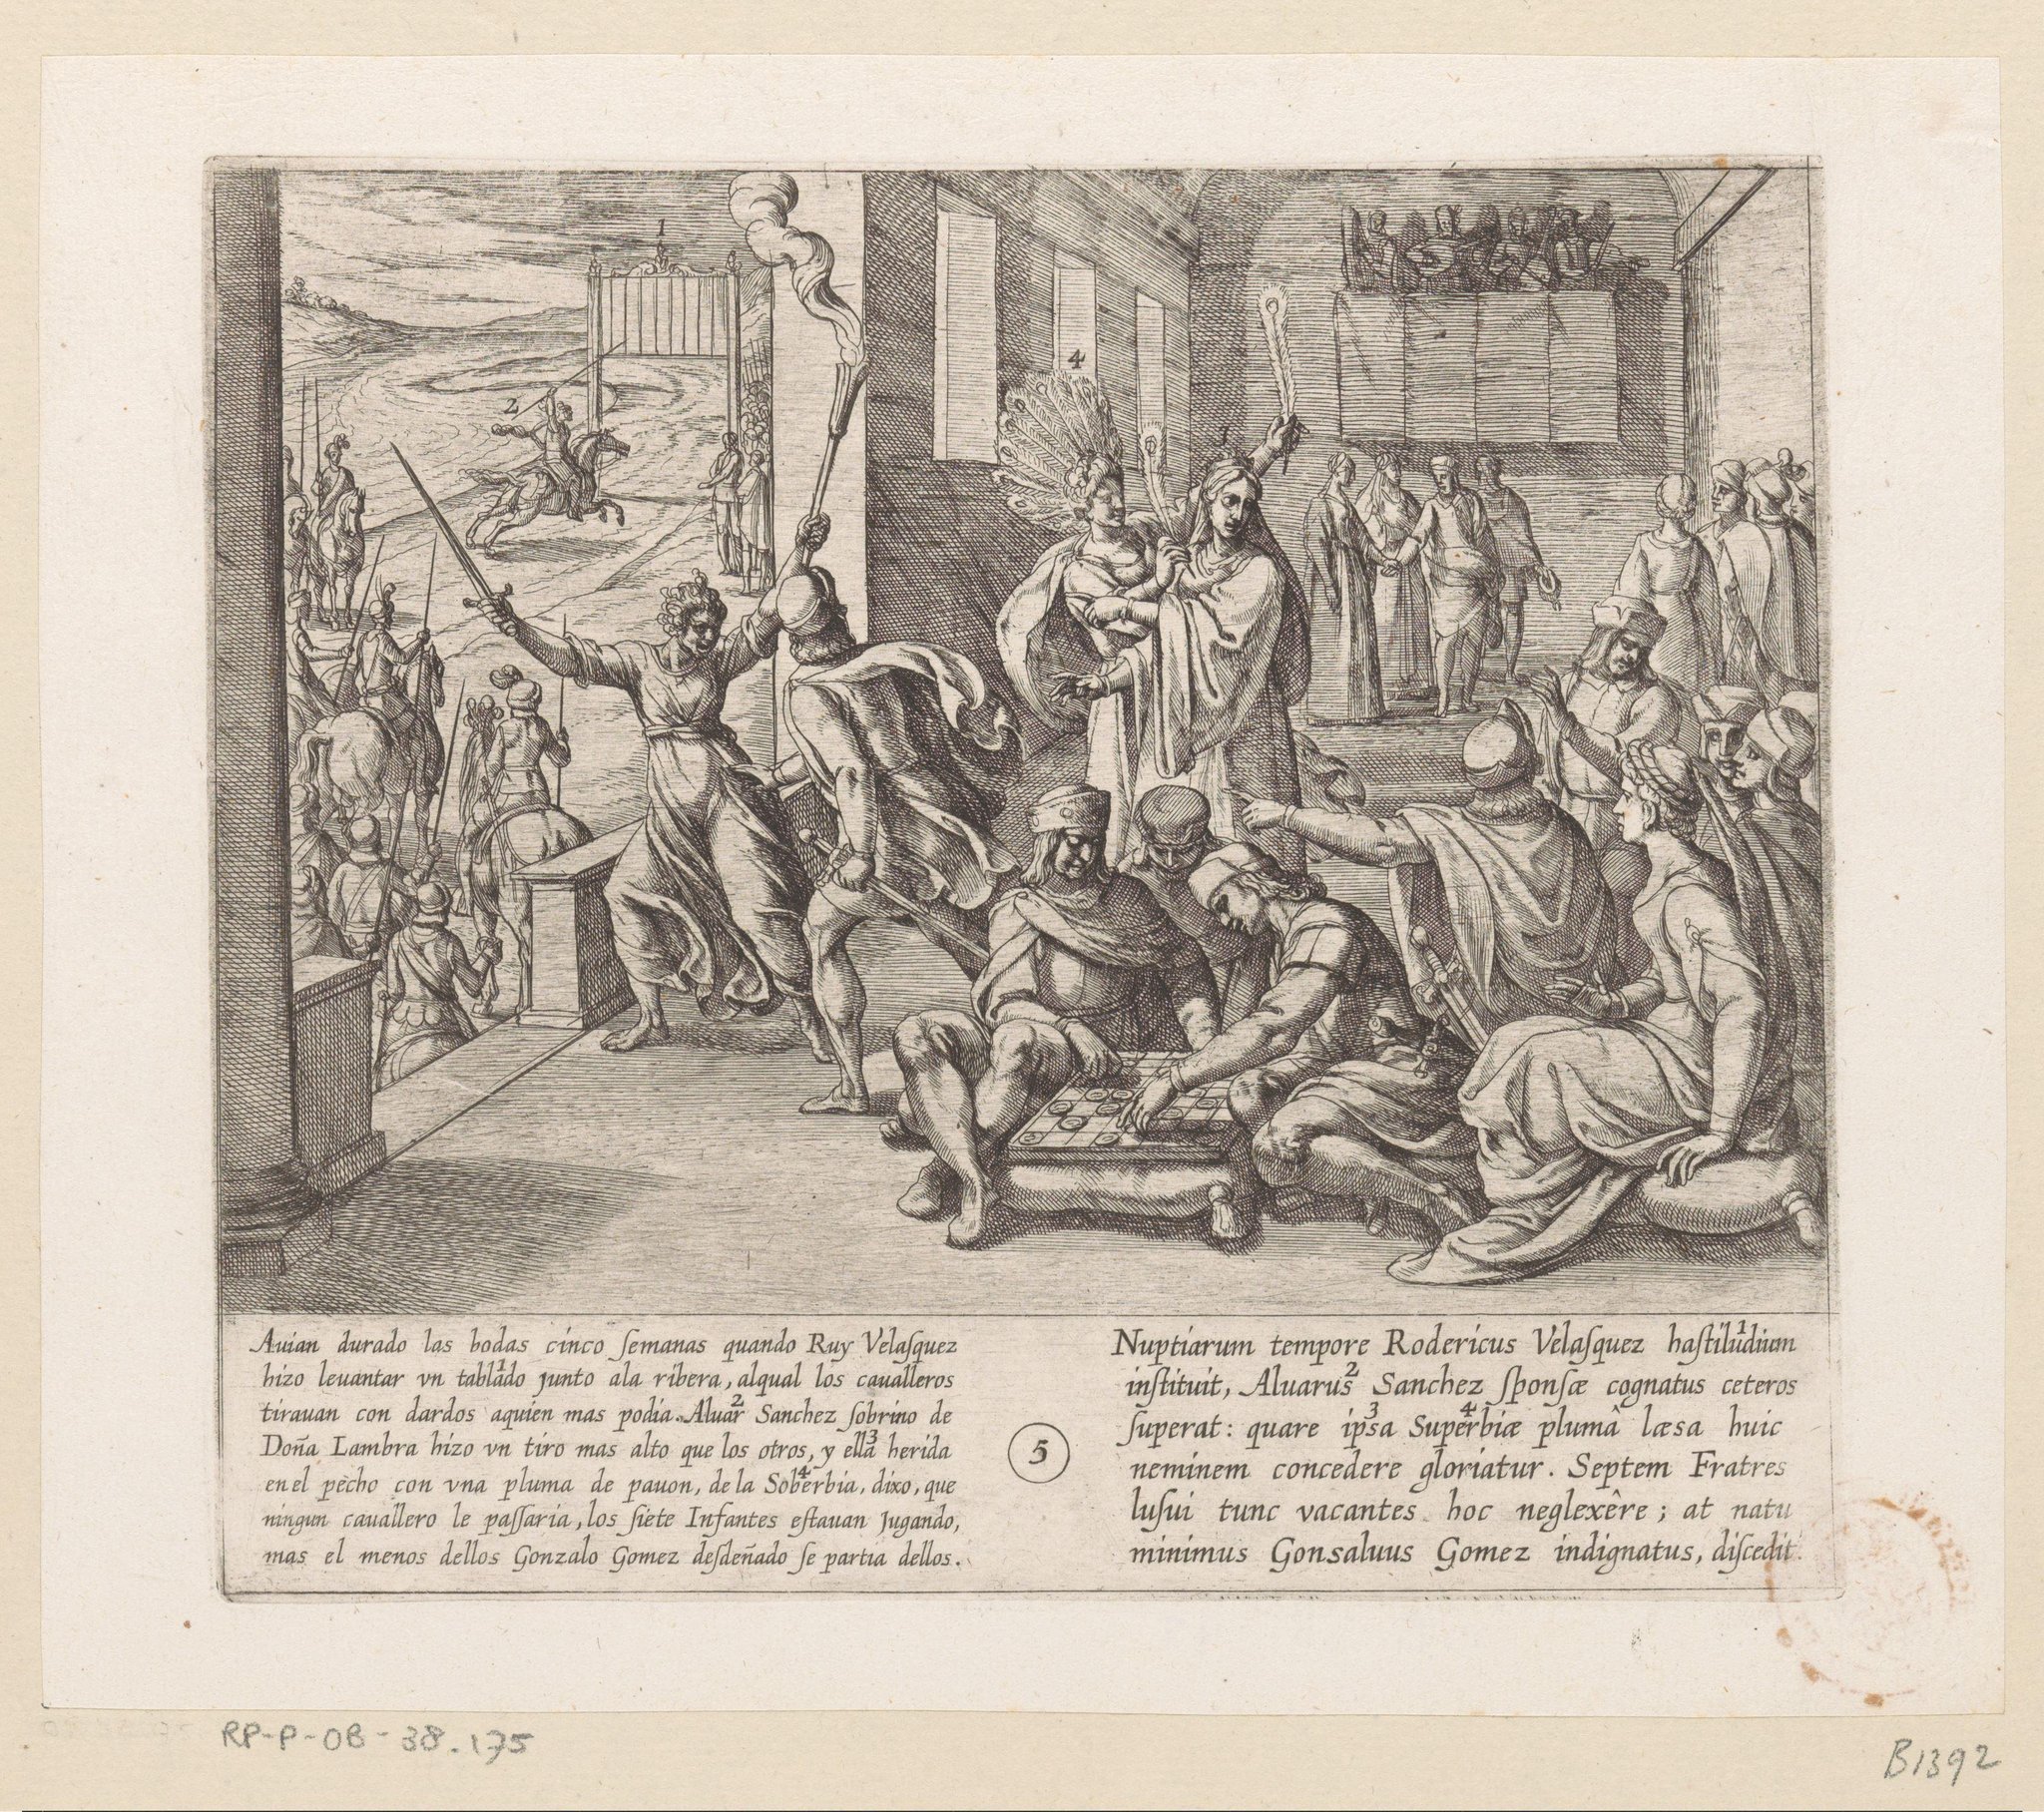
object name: print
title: De zeven infanten van Lara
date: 1612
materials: paper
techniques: etching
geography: antwerp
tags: palace, joust, tilt, tales and fairy tales, board-games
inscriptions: collector's mark: Lugt 240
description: Deze prent maakt deel uit van een reeks van 40 prenten (+ titelprent) met voorstellingen uit het volksverhaal over de zeven infanten van Lara.